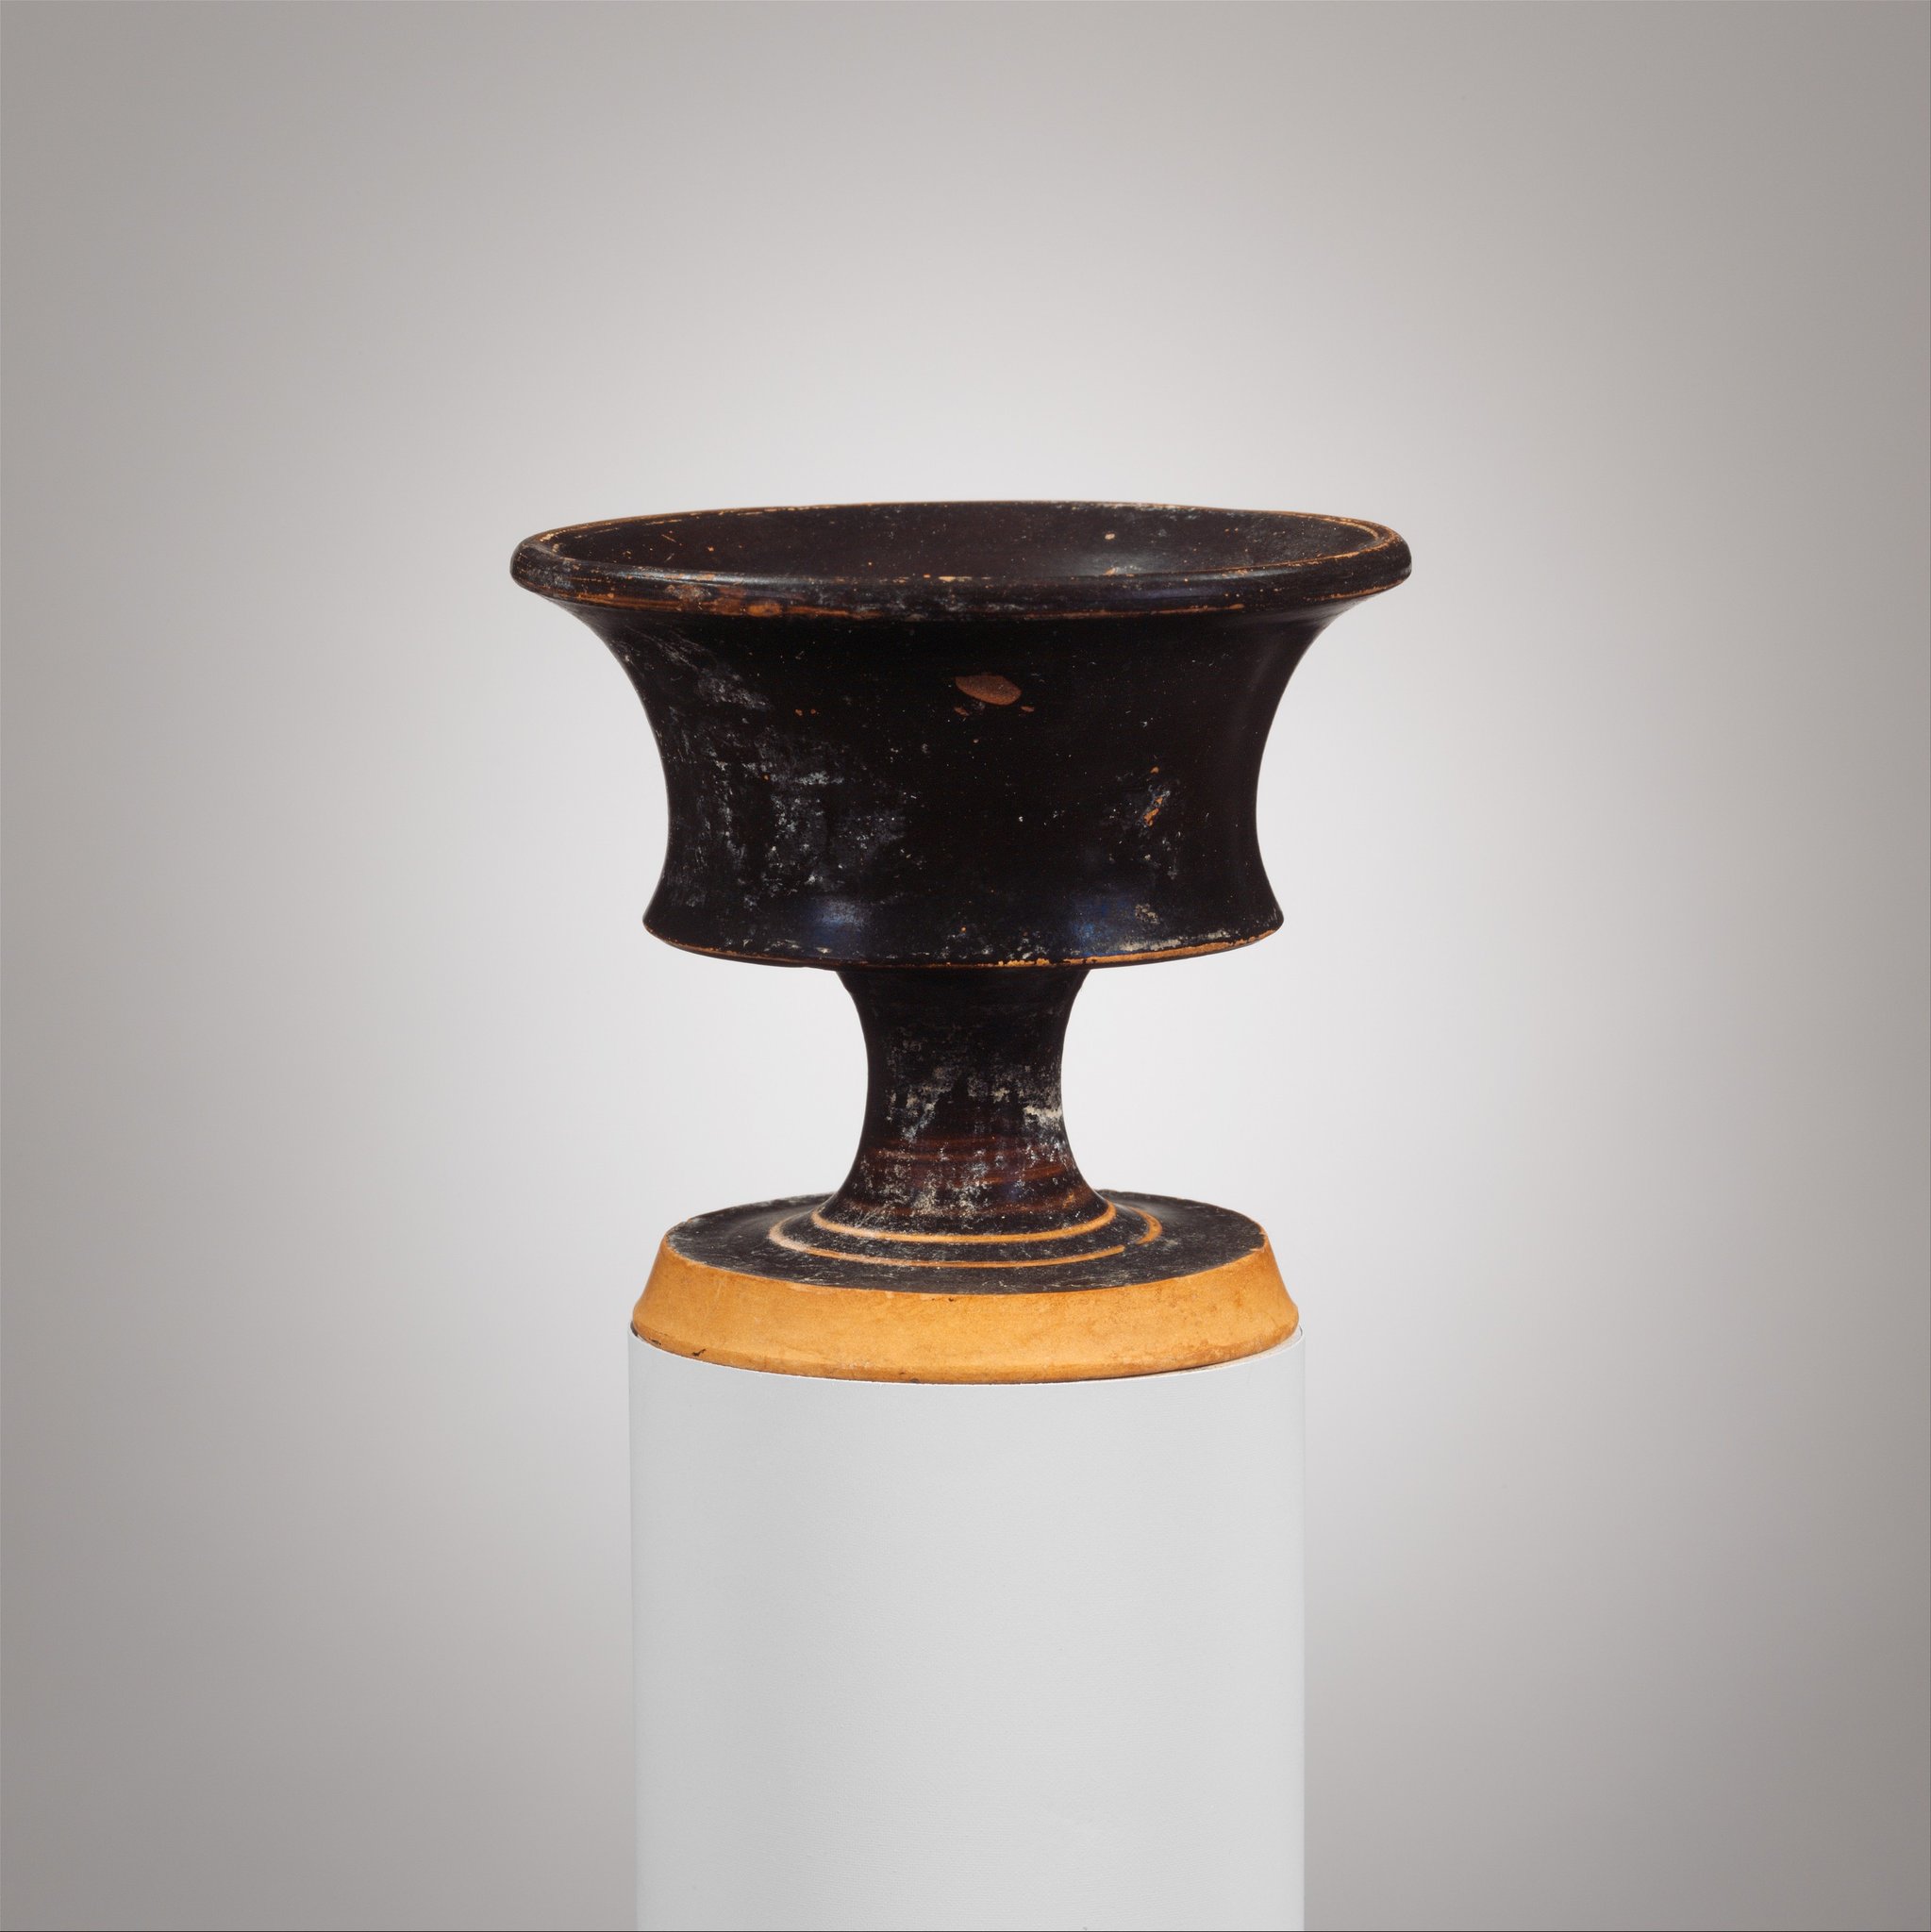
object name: calyx, stemmed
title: Terracotta stemmed calyx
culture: greek, attic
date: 500-468 BCE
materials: terracotta